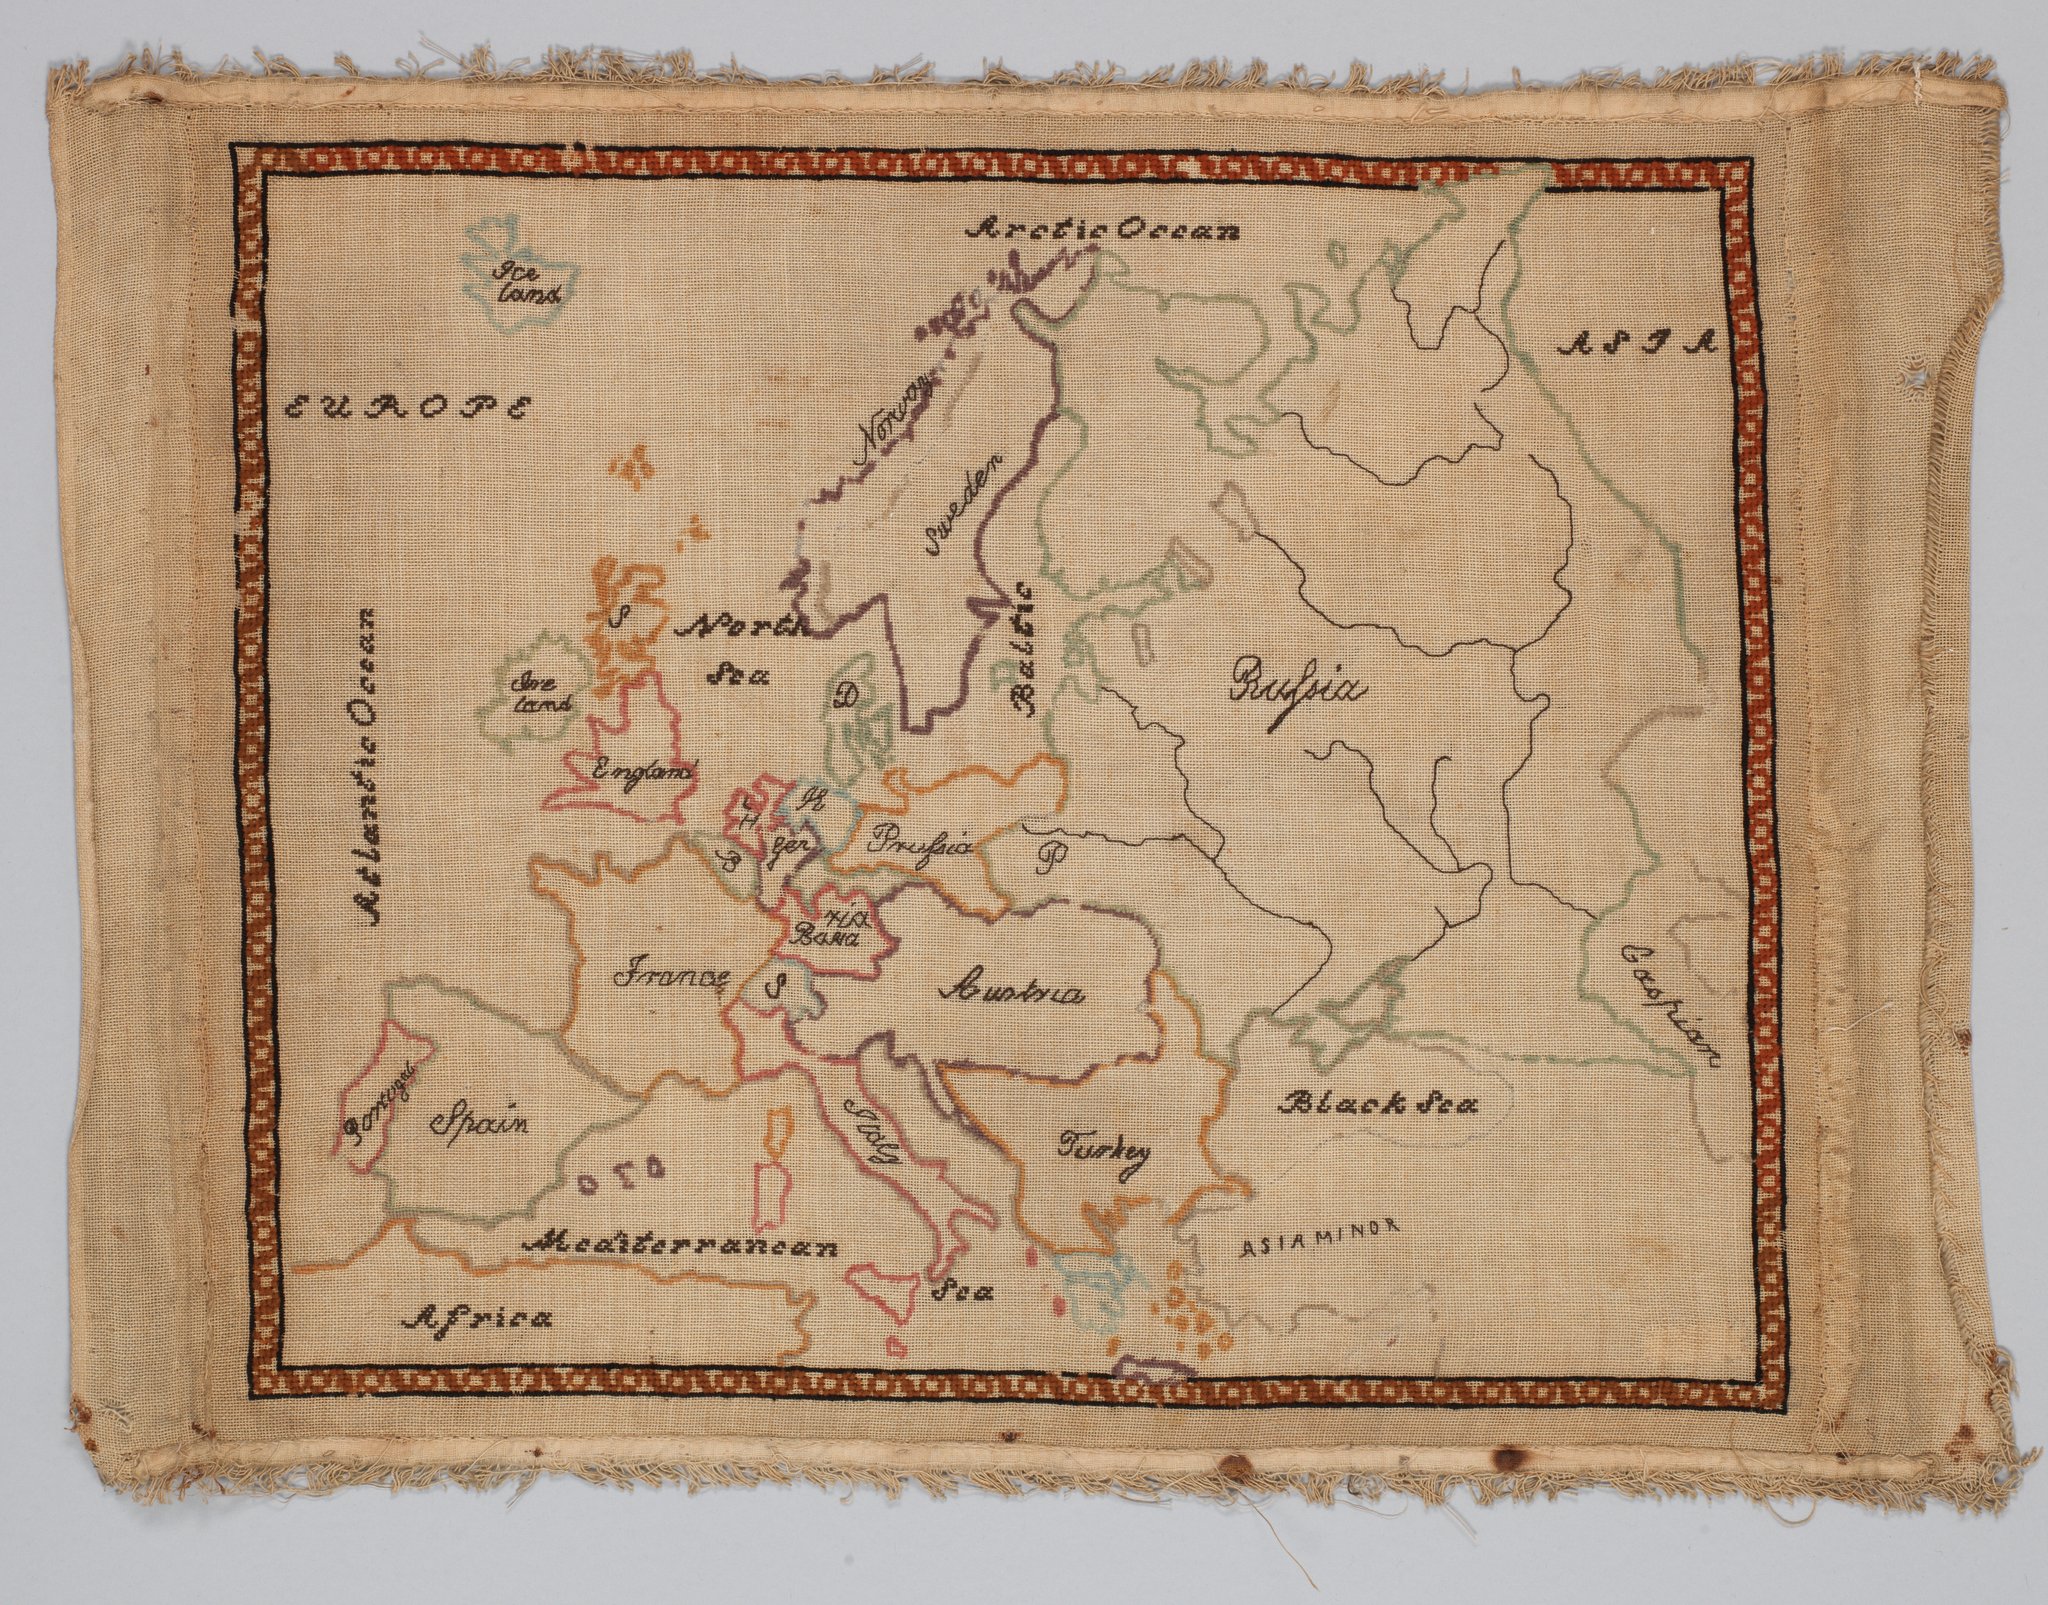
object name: sampler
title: Embroidered map sampler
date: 1801-1900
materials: canvas, cotton, silk, wool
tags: maps